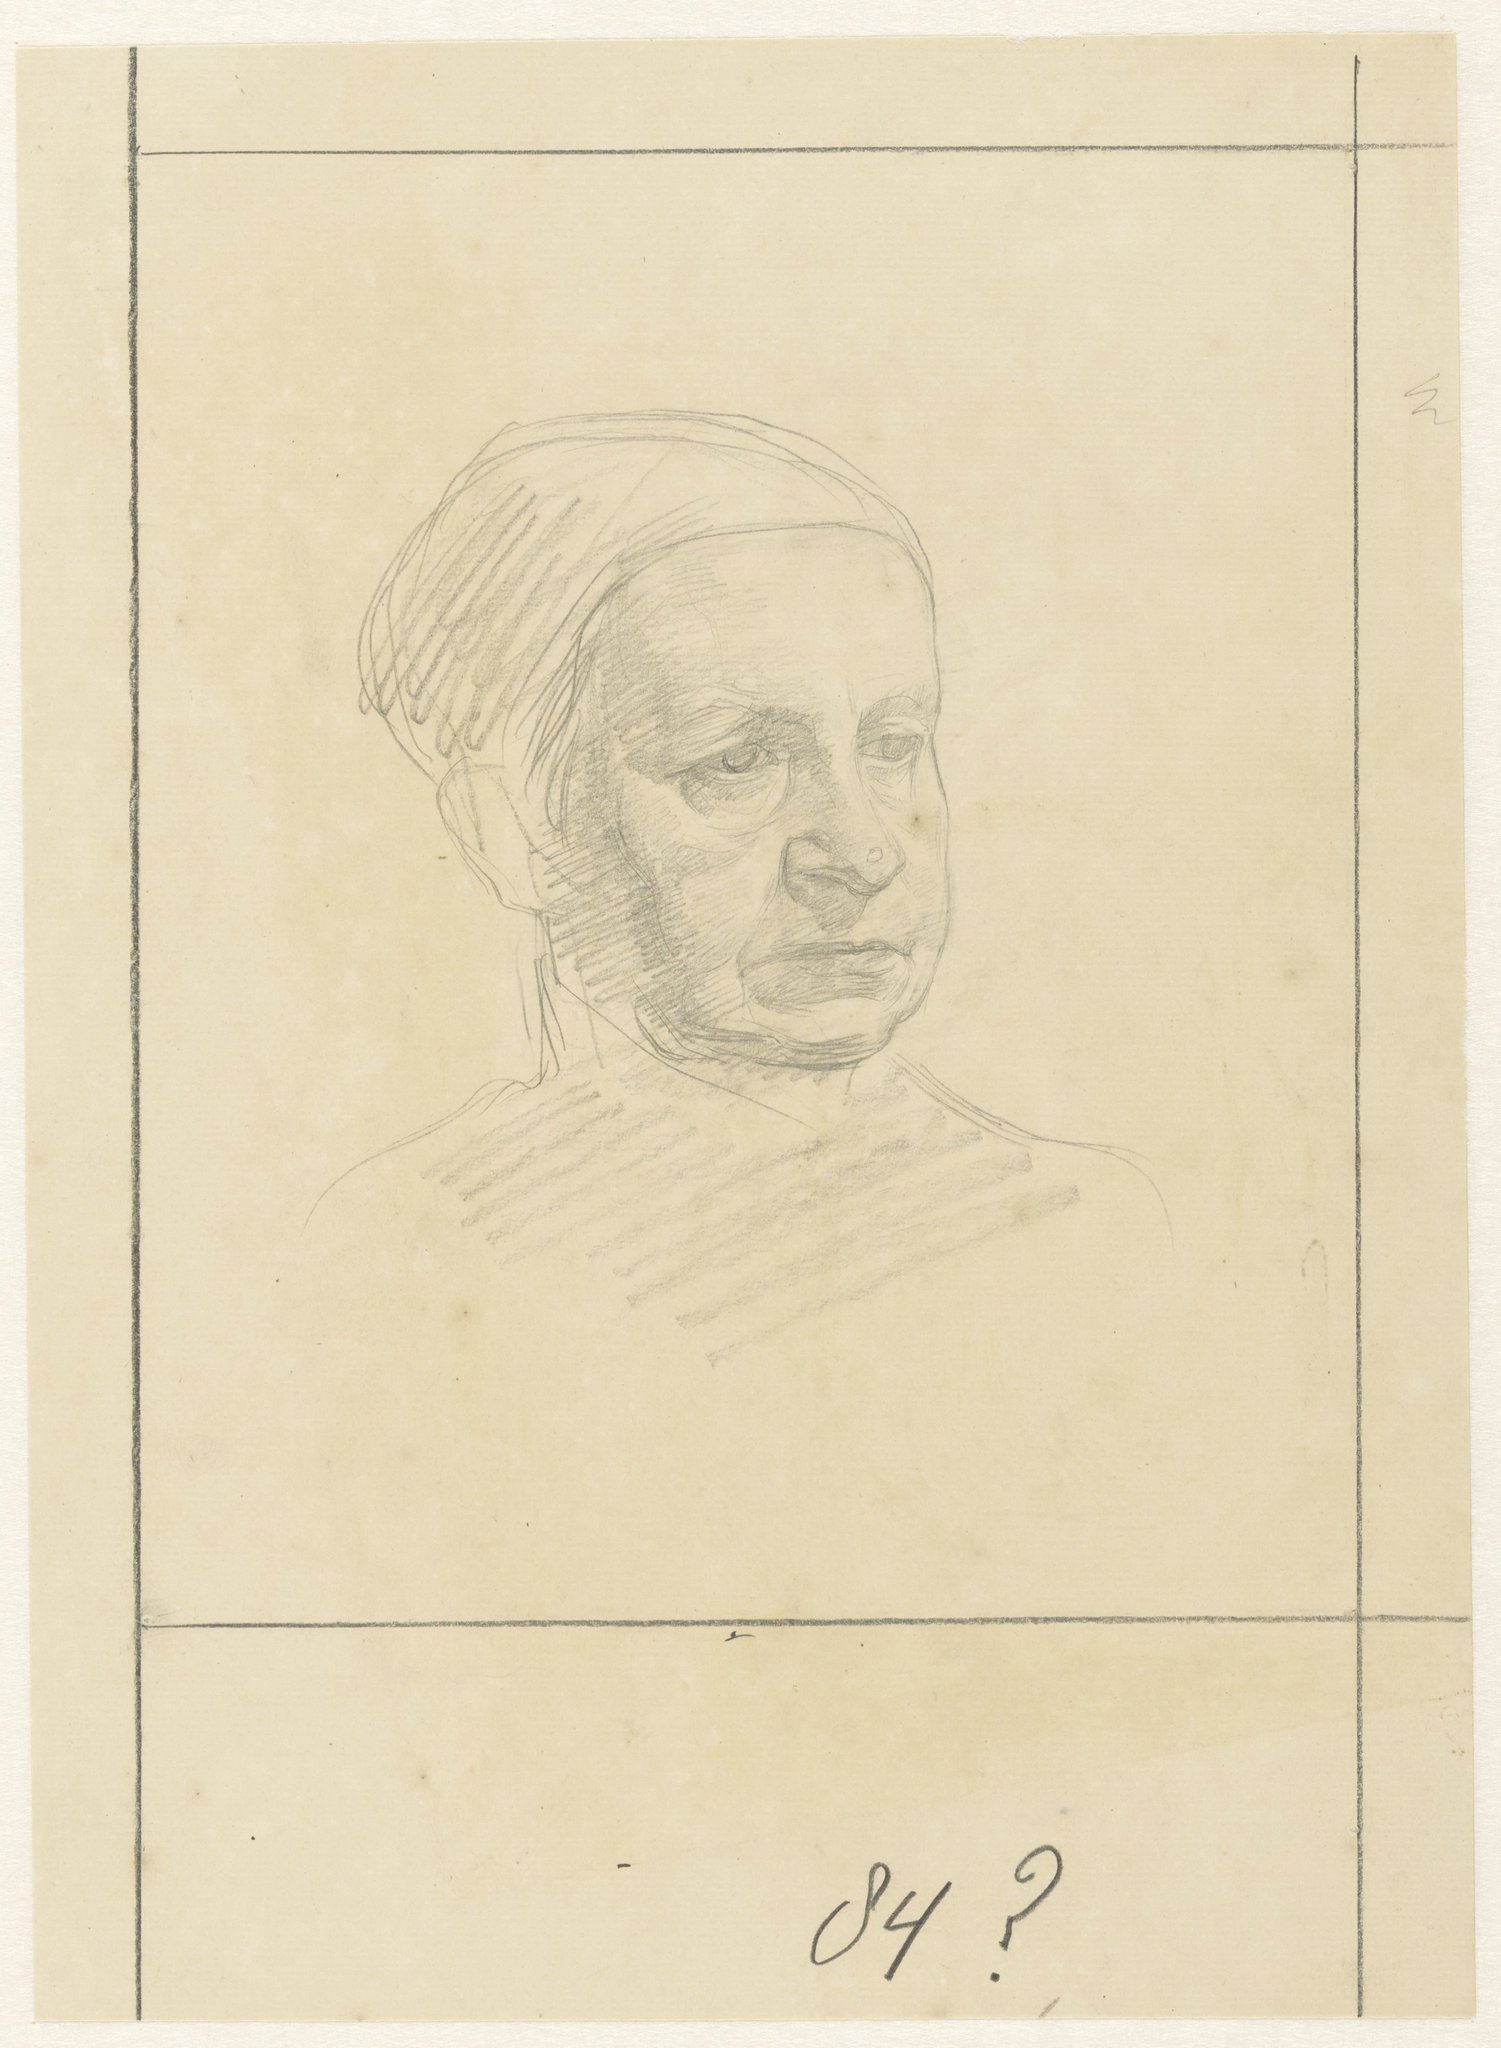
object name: drawing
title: Portret van mevrouw Anna Cornelia Veth-Giltay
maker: jan veth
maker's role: designer, draughtsman, painter, print maker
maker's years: 1864-1925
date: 1874-1925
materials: paper, pencil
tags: historical persons